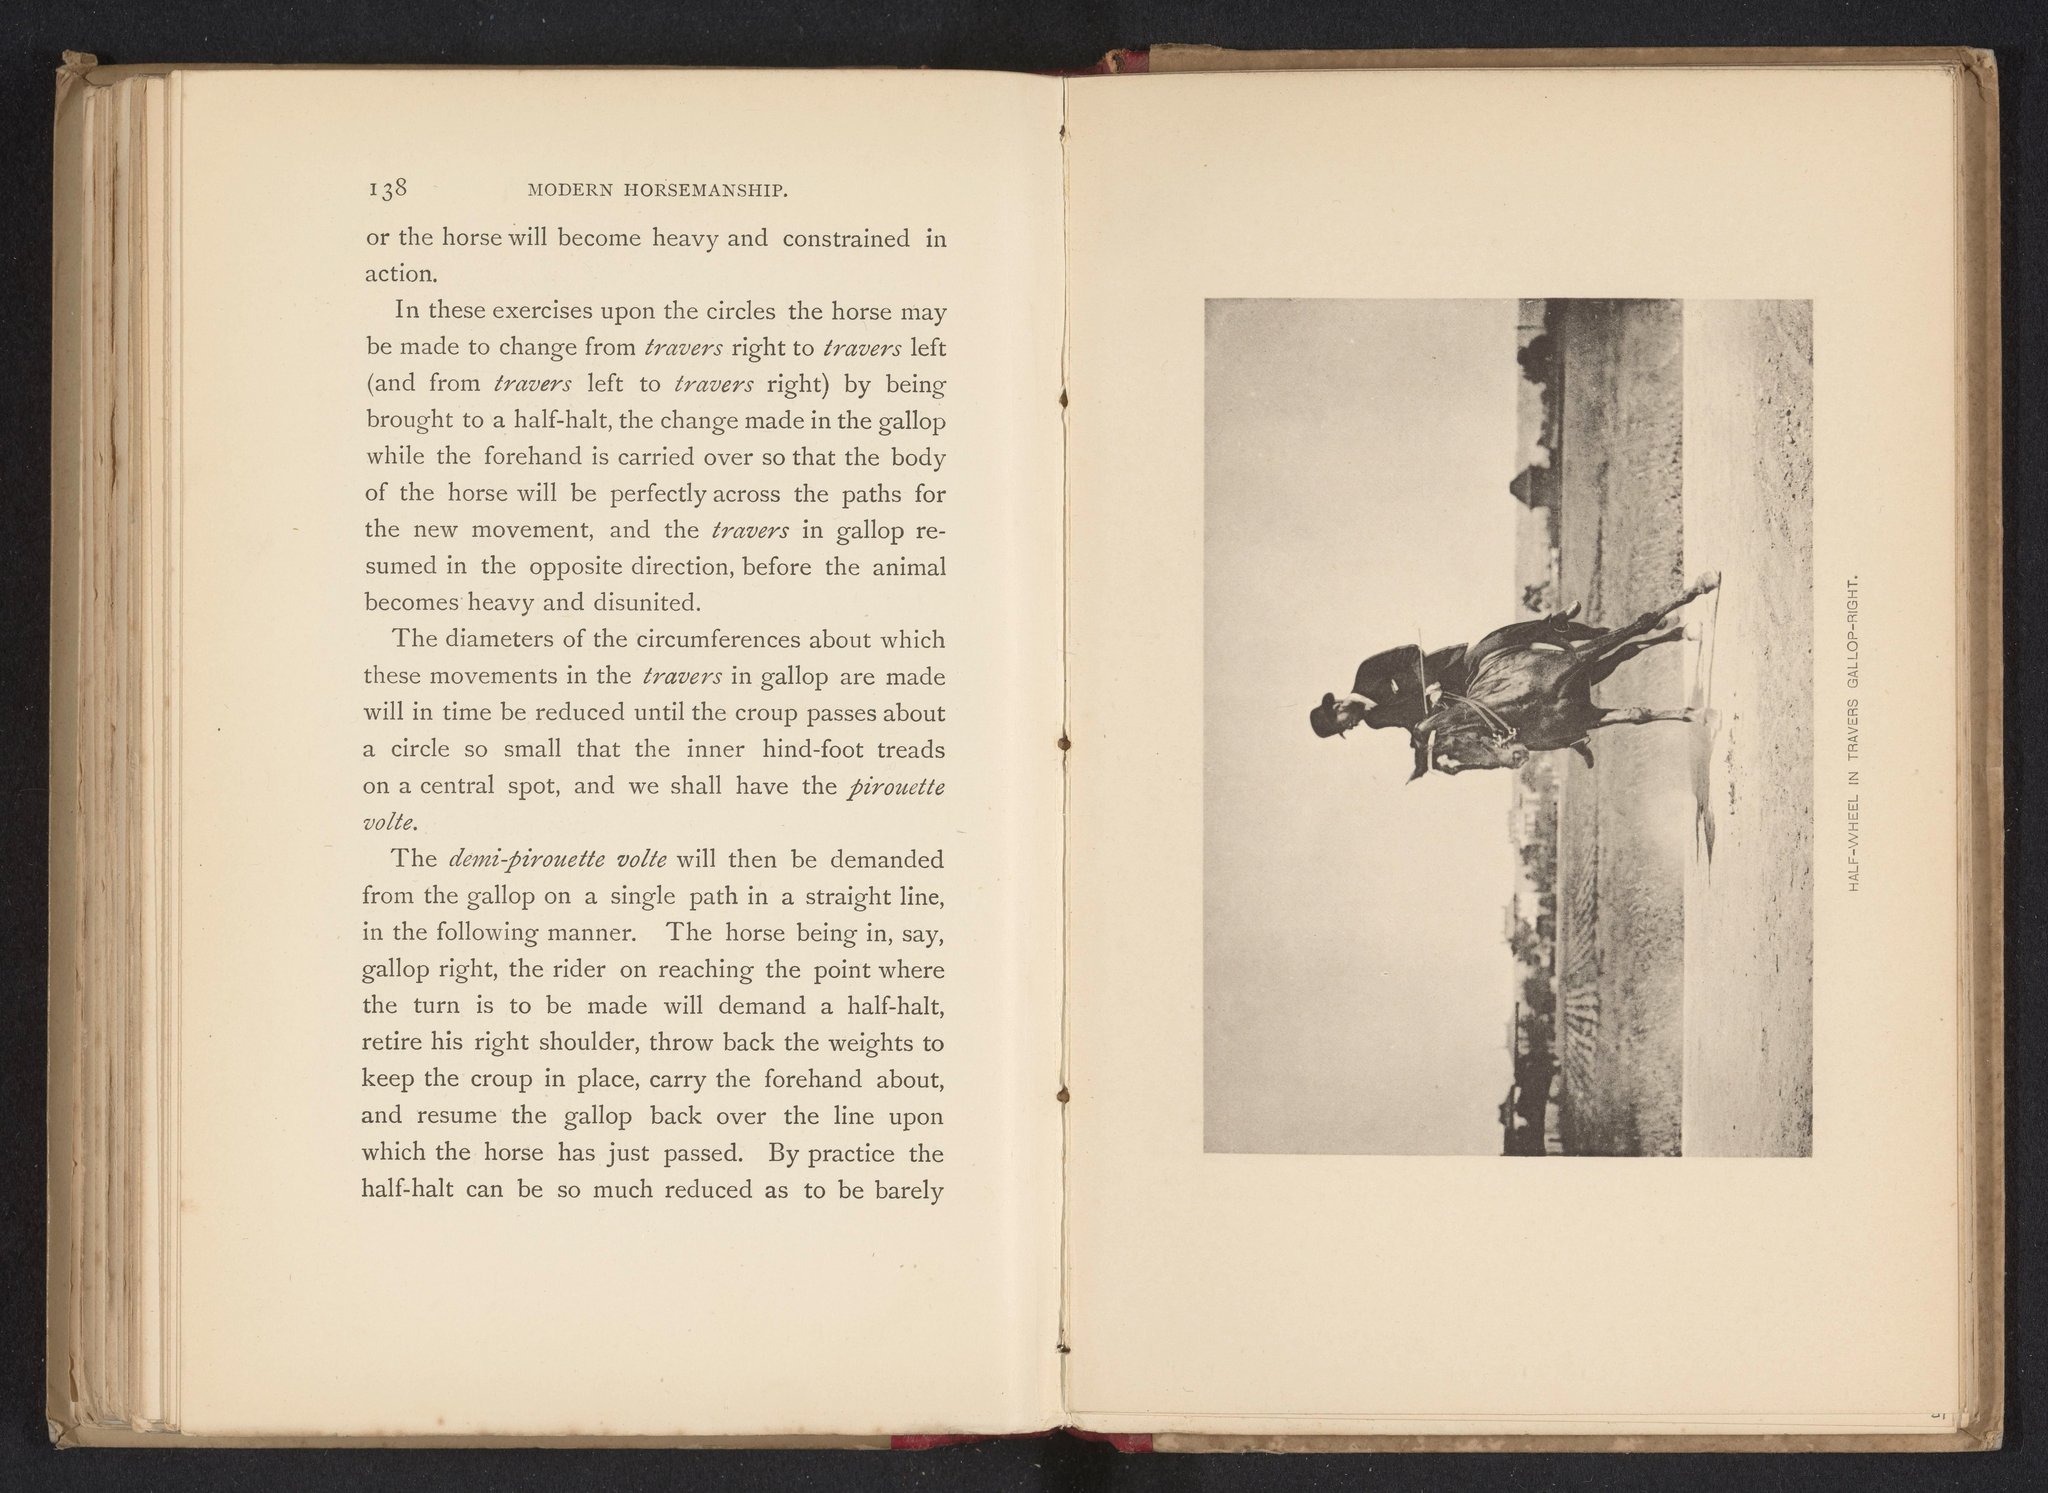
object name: photomechanical print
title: Man op een paard in zijwaartse galop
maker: Anonymous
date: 1879-1889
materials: paper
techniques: photograph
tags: riding a horse, ass, or mule; rider, horseman, head-gear: bowler hat, galloping horse